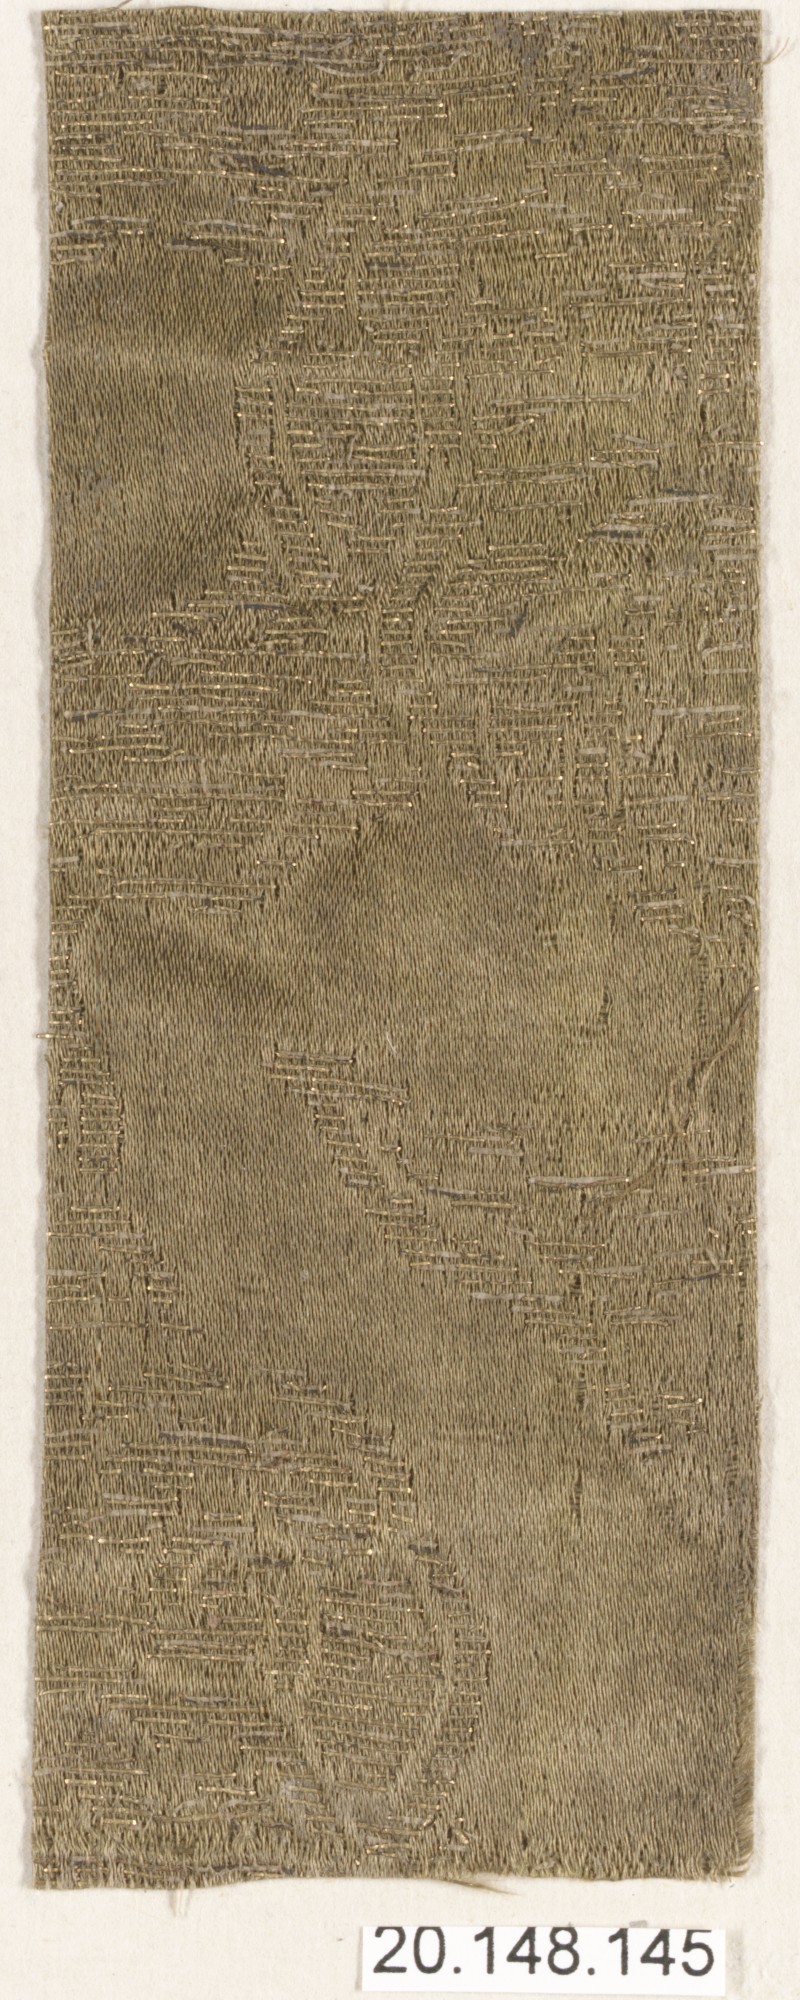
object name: piece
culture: japanese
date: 1601-1700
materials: silk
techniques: compound weave